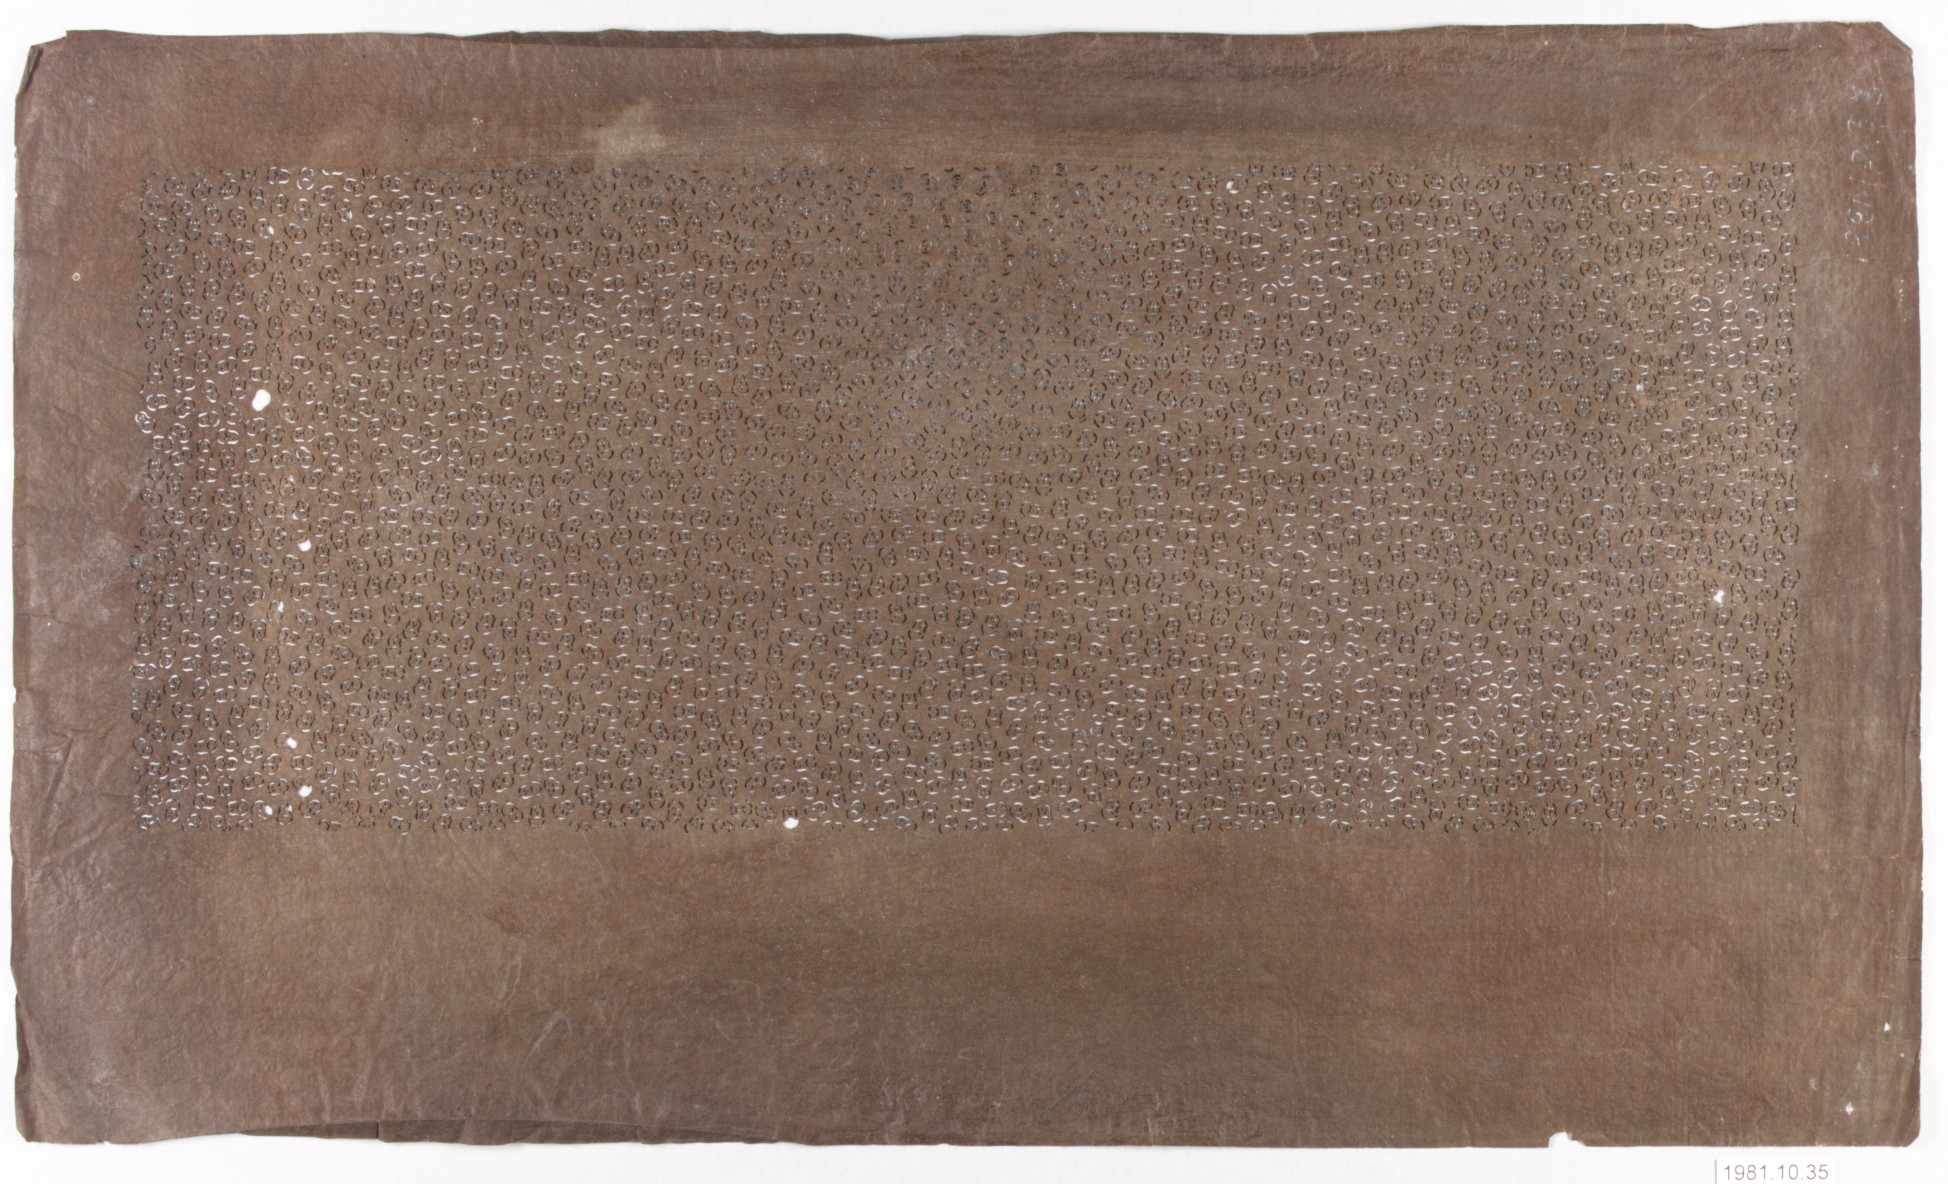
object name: stencil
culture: japanese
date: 1801-1900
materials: paper